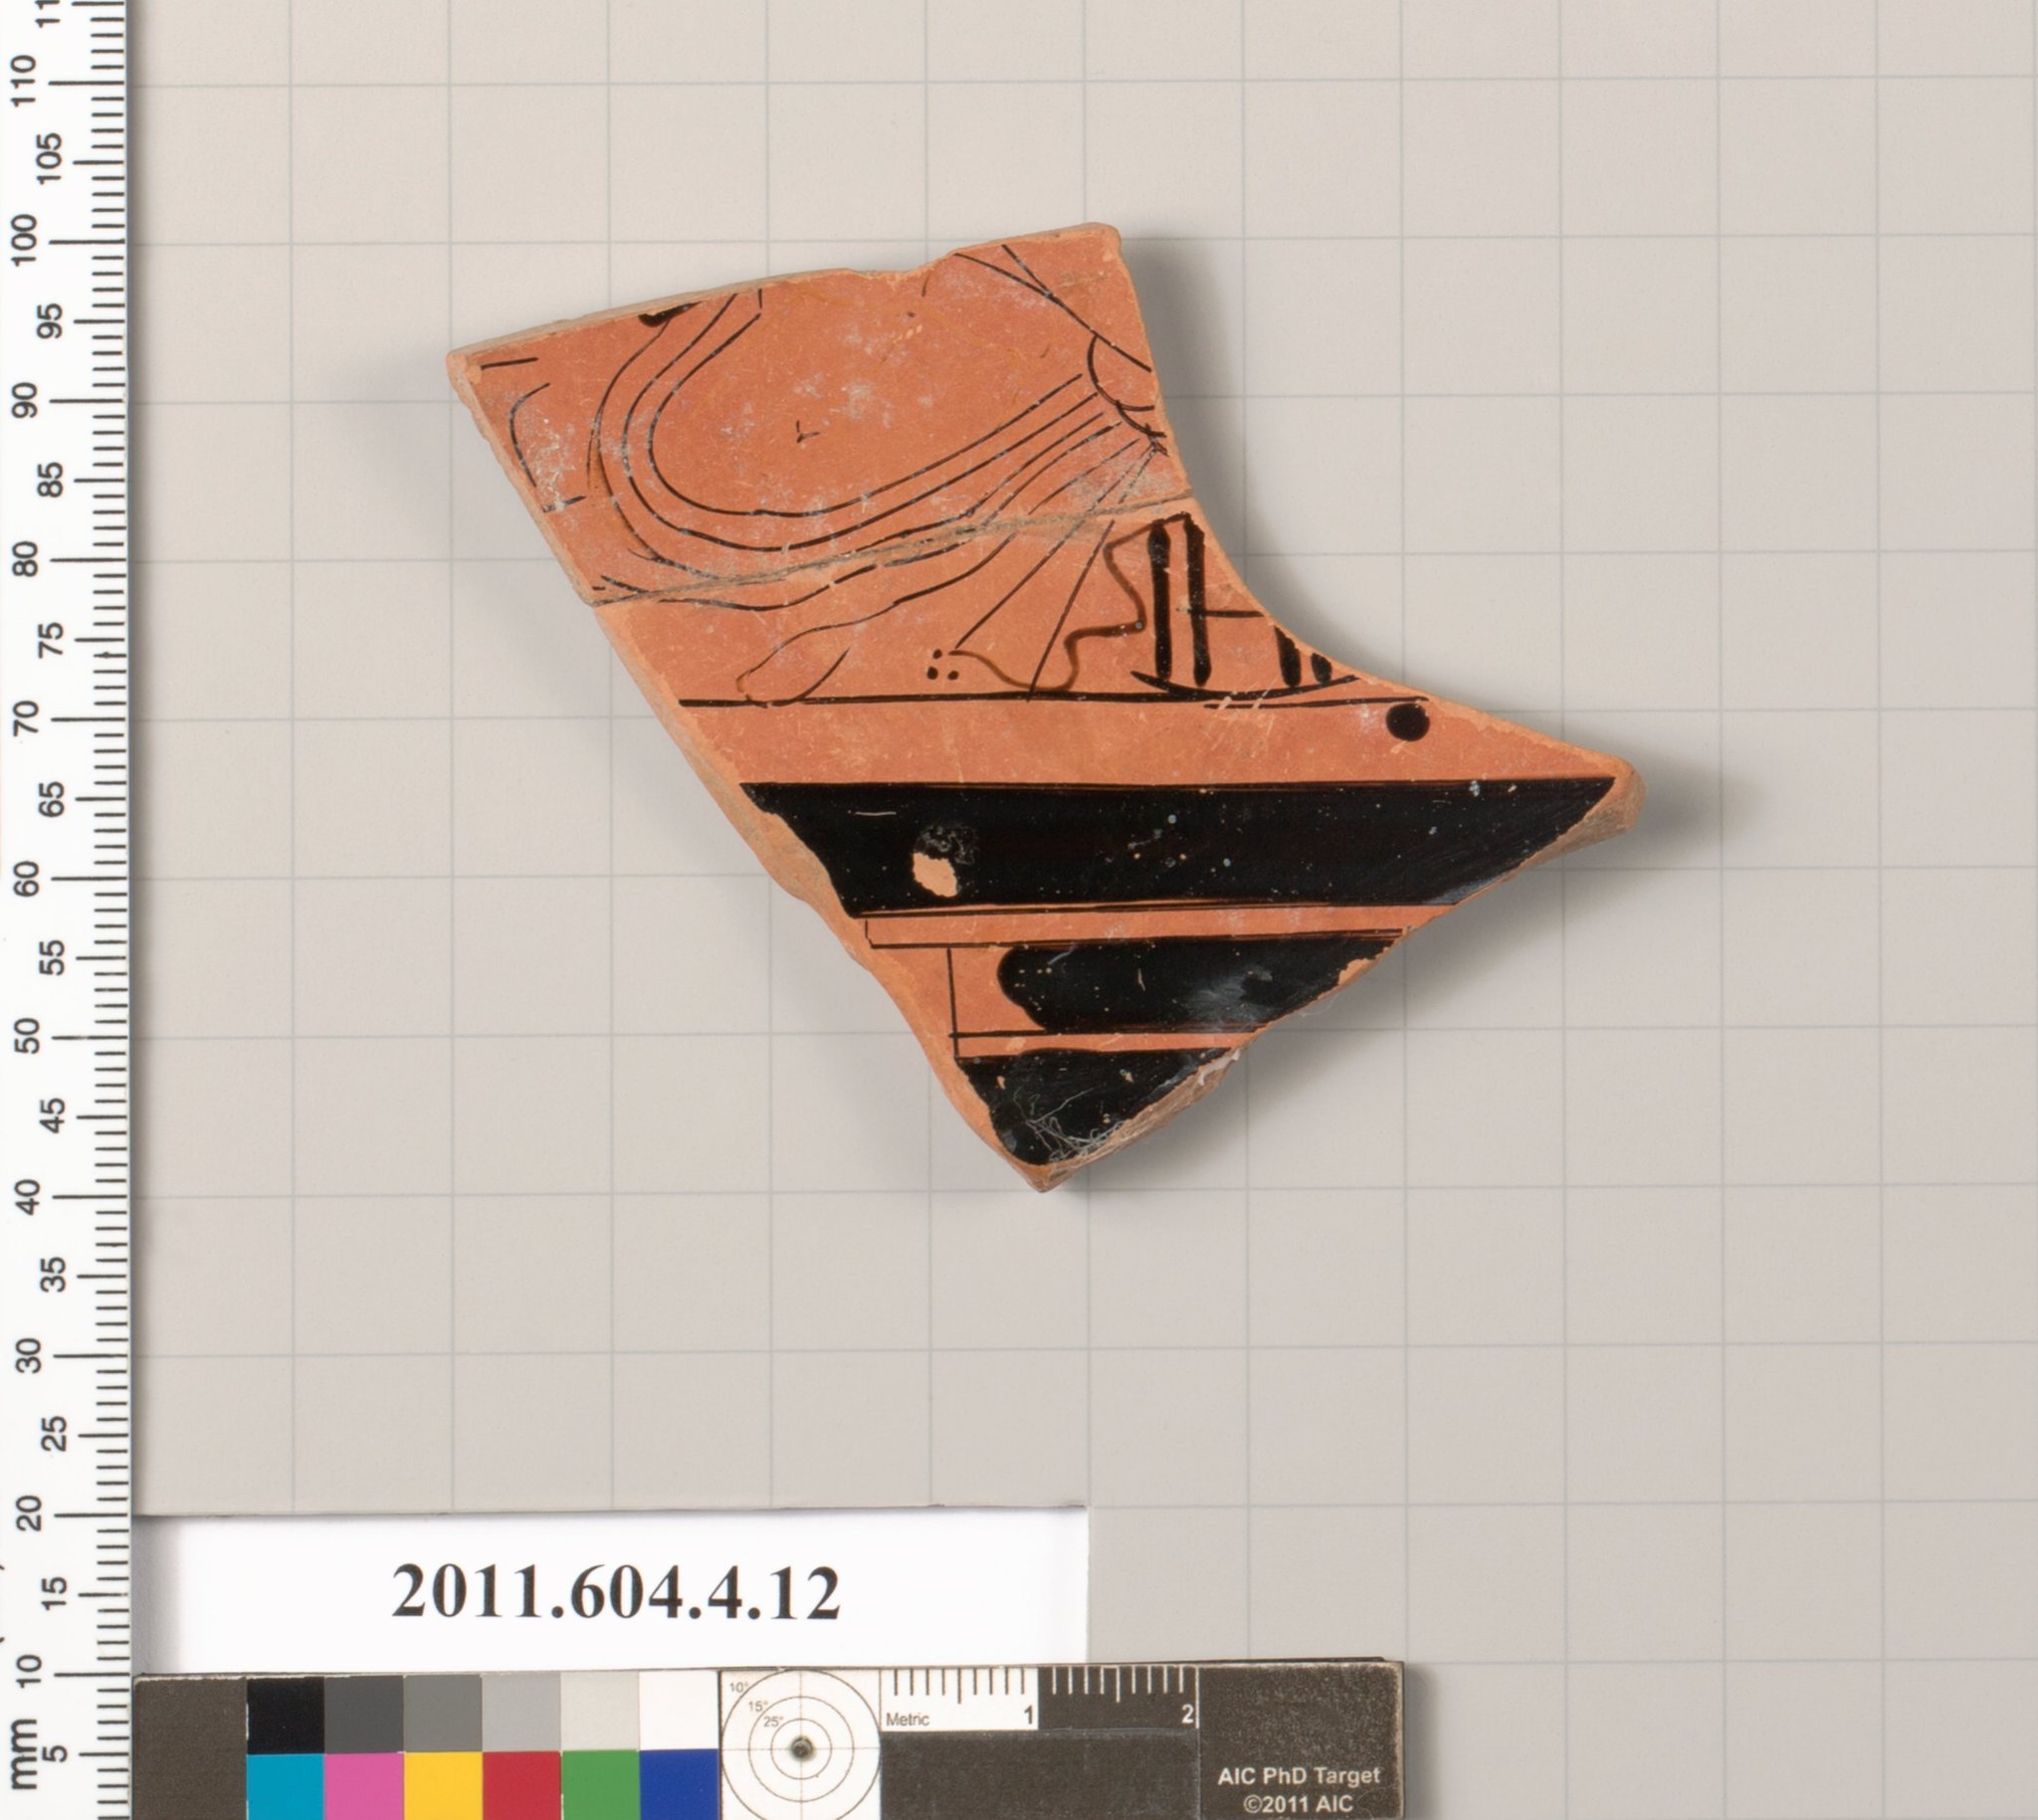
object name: kylix fragment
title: Terracotta fragment of a kylix (drinking cup)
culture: greek, attic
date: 467-435 BCE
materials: terracotta